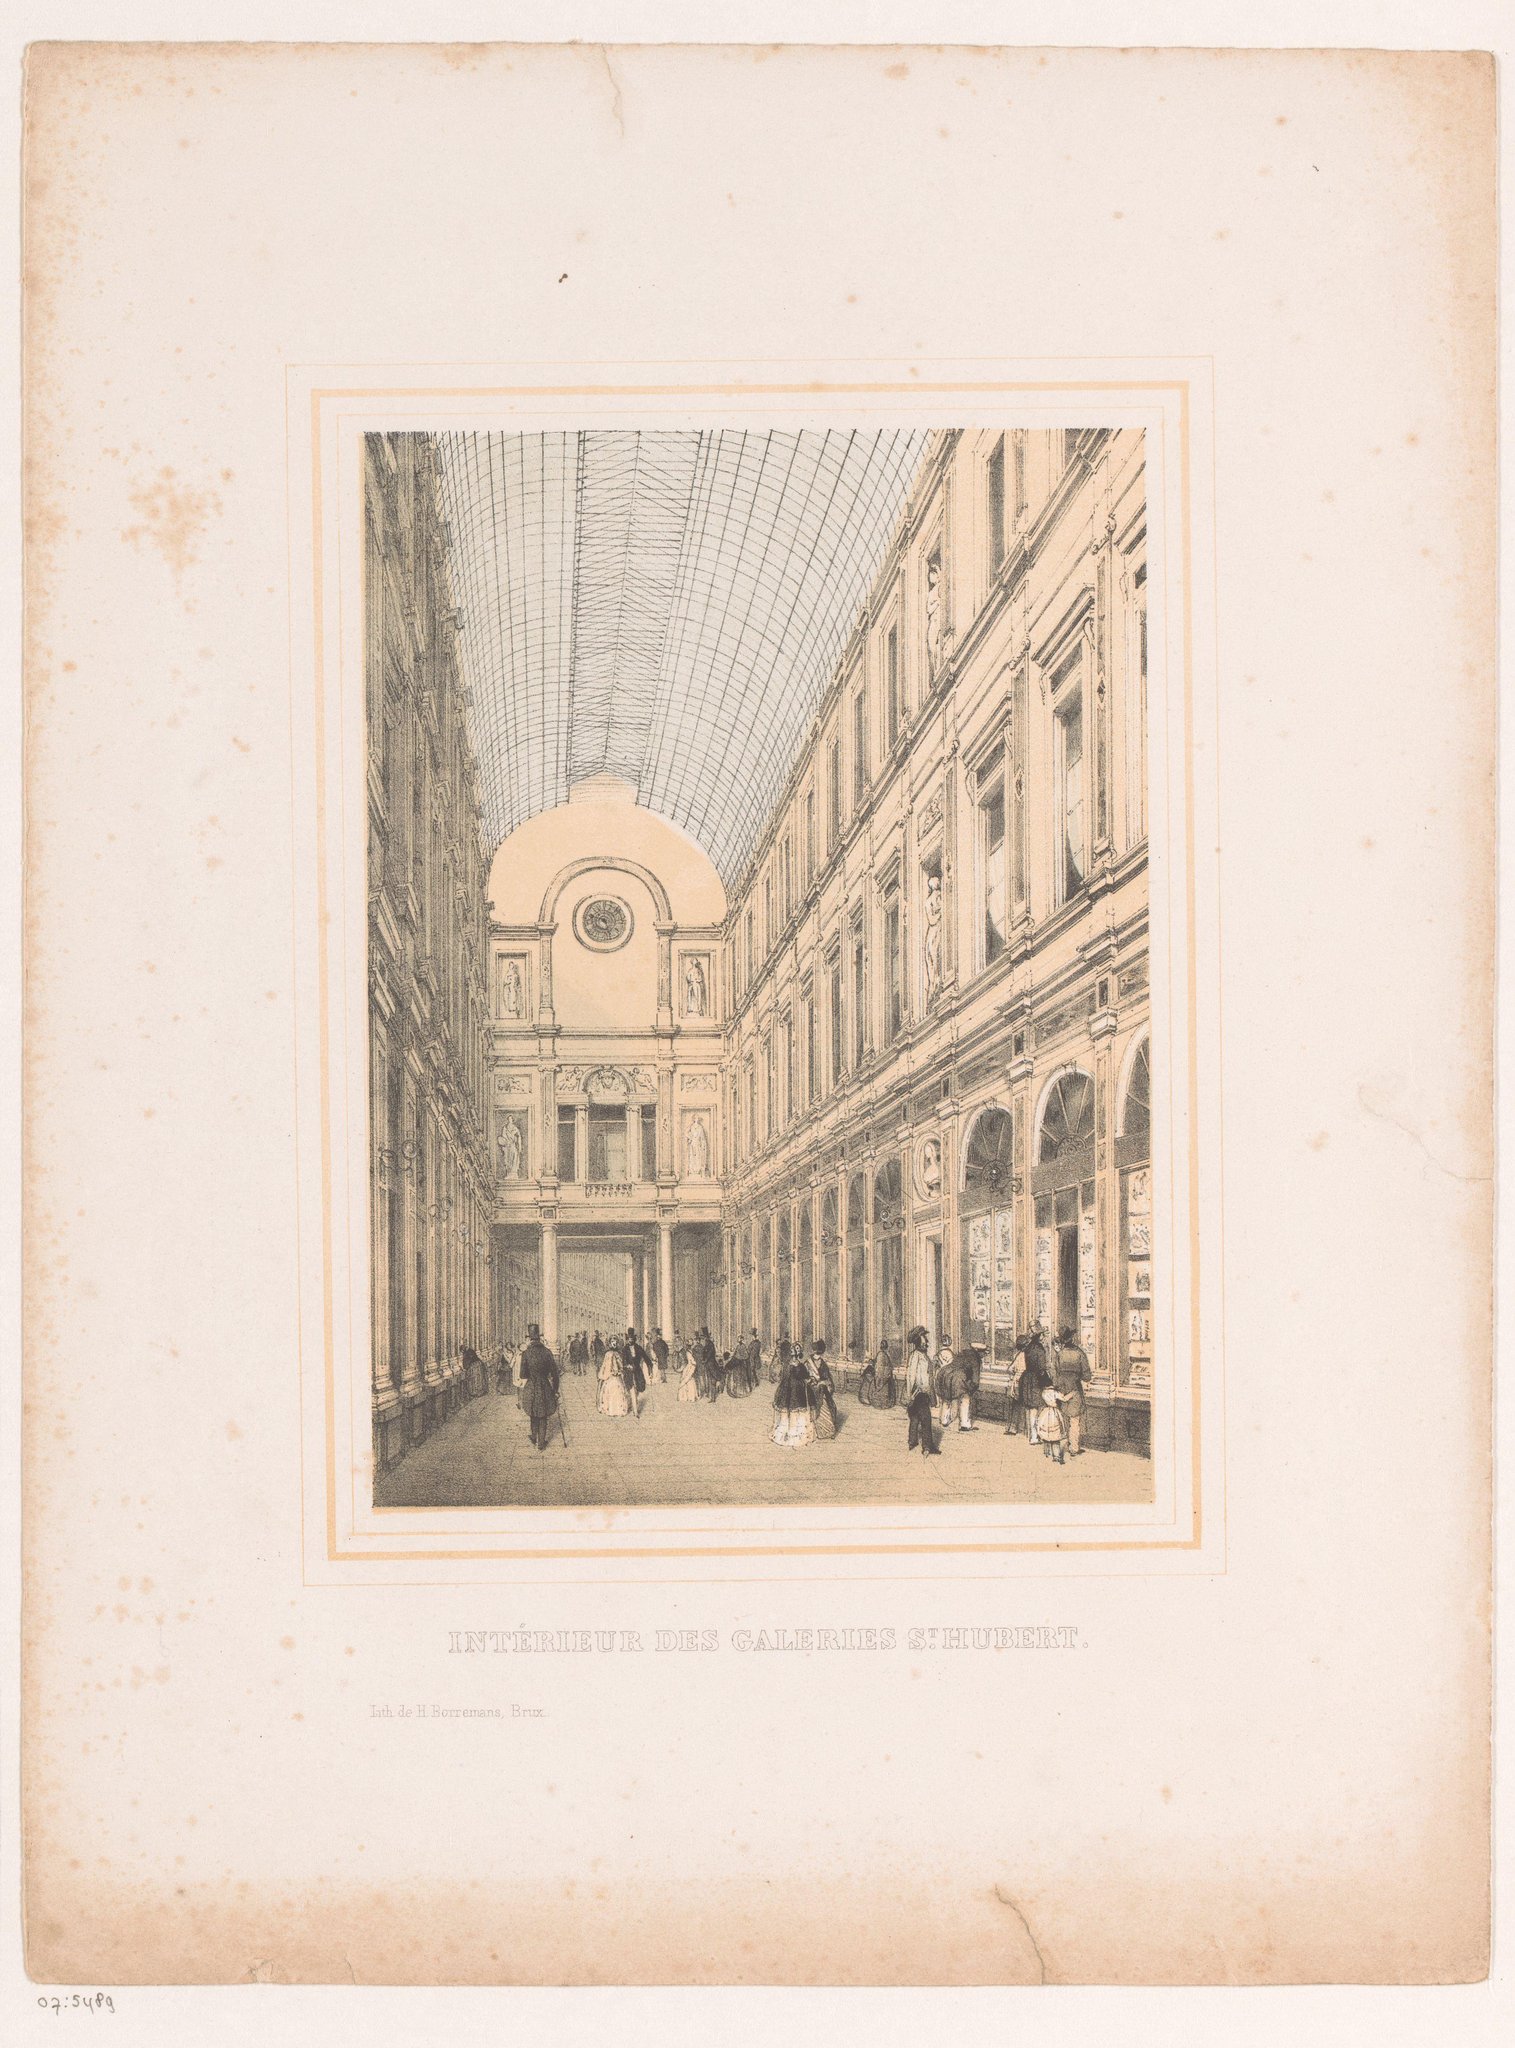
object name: print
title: Intérieur des galeries St. Hubert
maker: henri borremans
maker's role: print maker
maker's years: 1800-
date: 1834-1862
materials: paper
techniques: tone lithography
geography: brussels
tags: civic architecture; edifices; dwellings - aa - civic architecture: inside, gallery (spacious corridor), brussels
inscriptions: collector's mark: Lugt 2228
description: Prent behoort waarschijnlijk tot een serie prenten met gezichten op Brussel en omstreken.